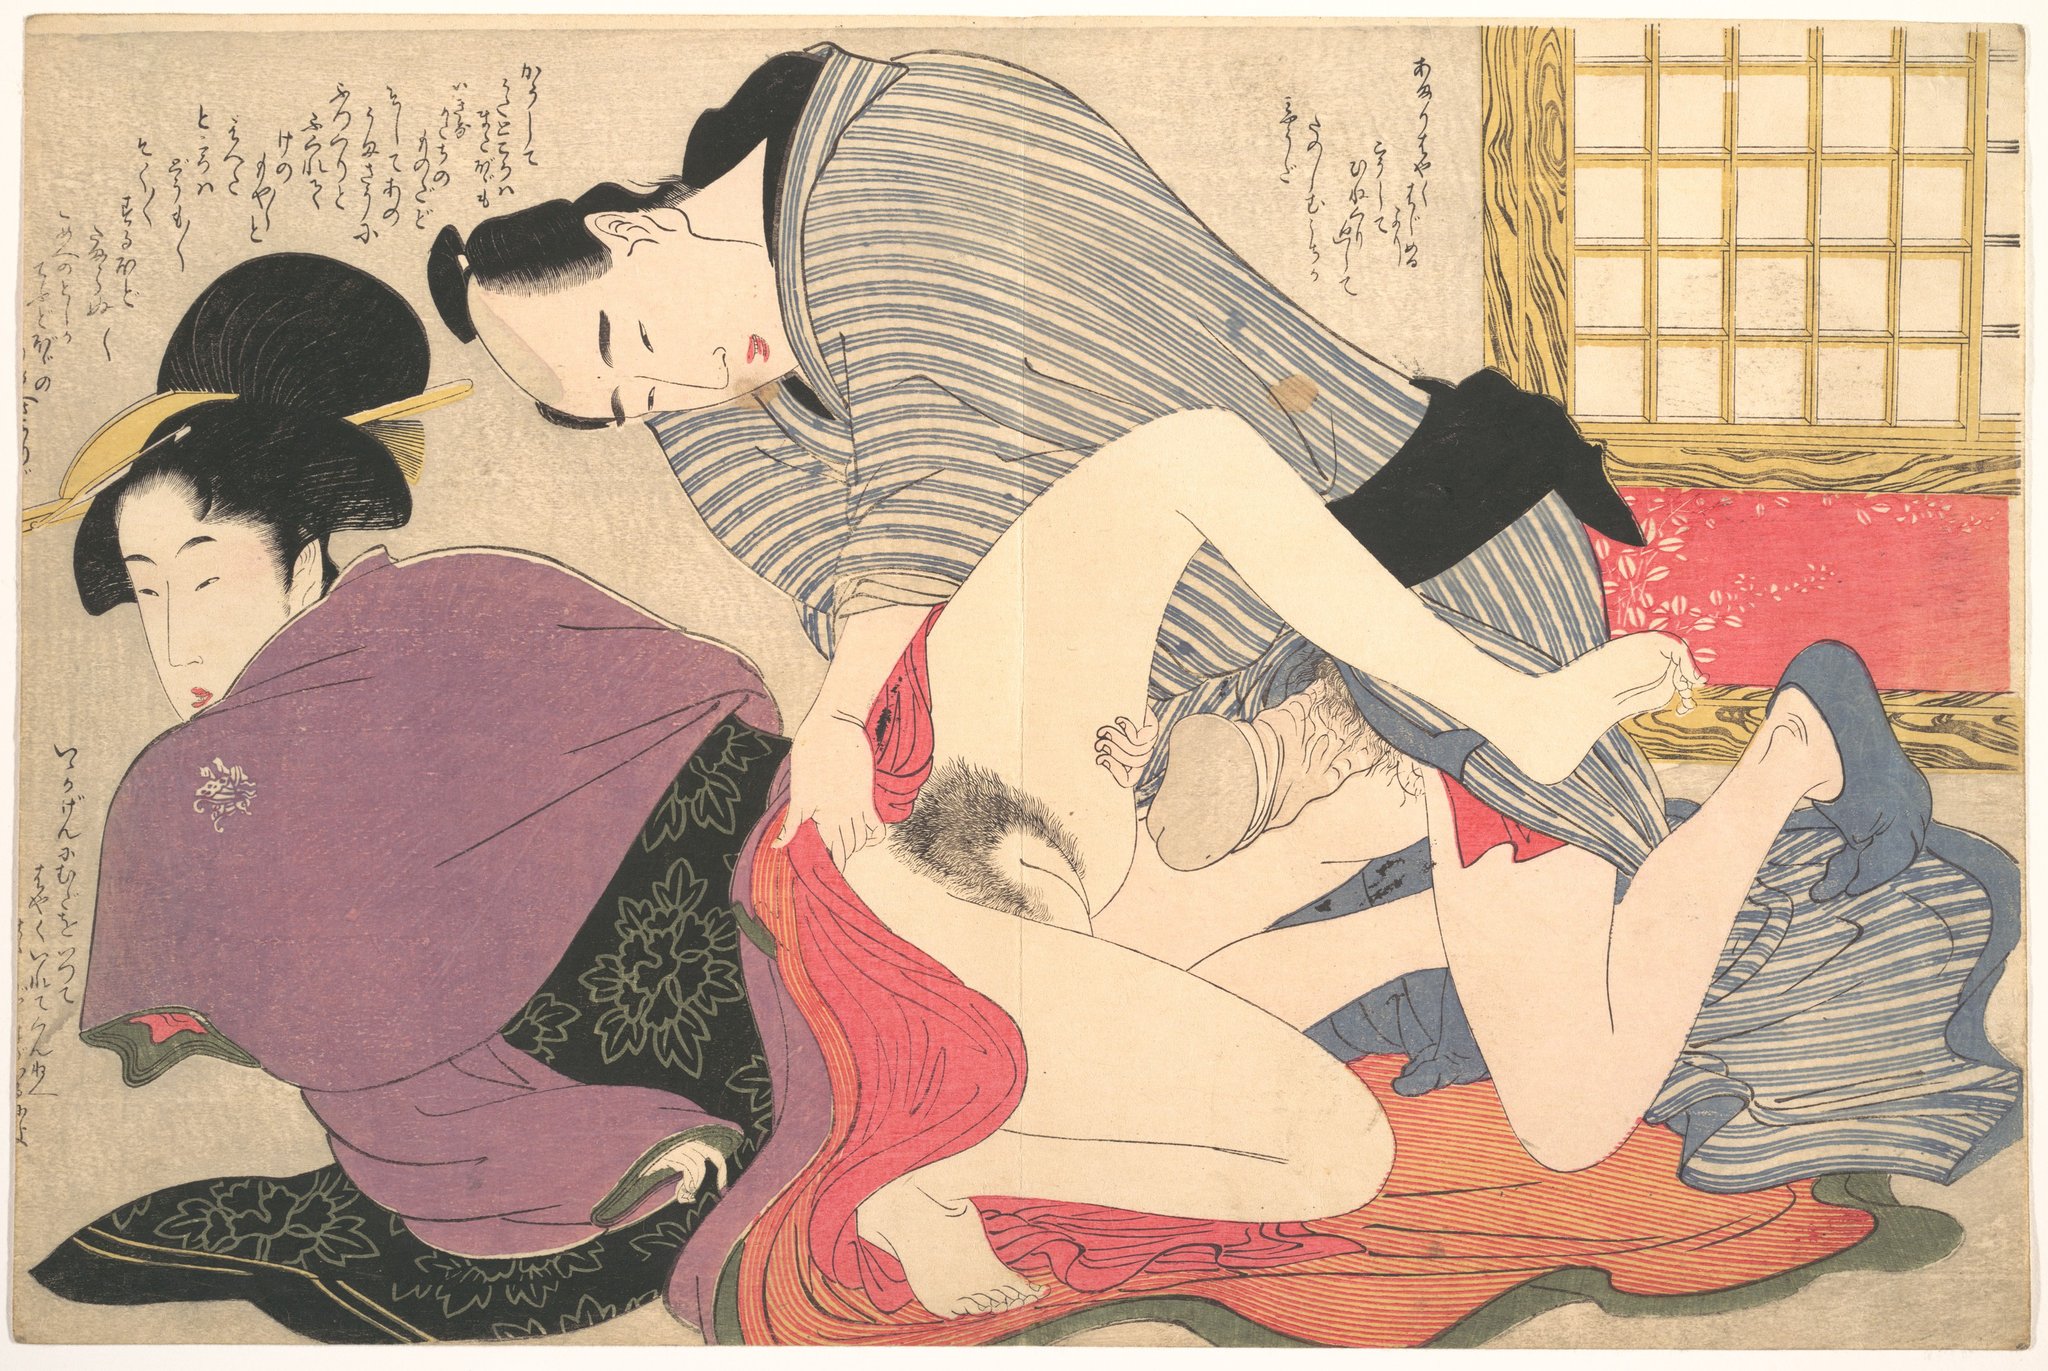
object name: print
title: Erotic Print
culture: japanese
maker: kitagawa utamaro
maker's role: artist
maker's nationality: japanese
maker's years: 1754-1806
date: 1753-1806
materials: ink, paper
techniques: woodblock print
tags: male nudes,female nudes